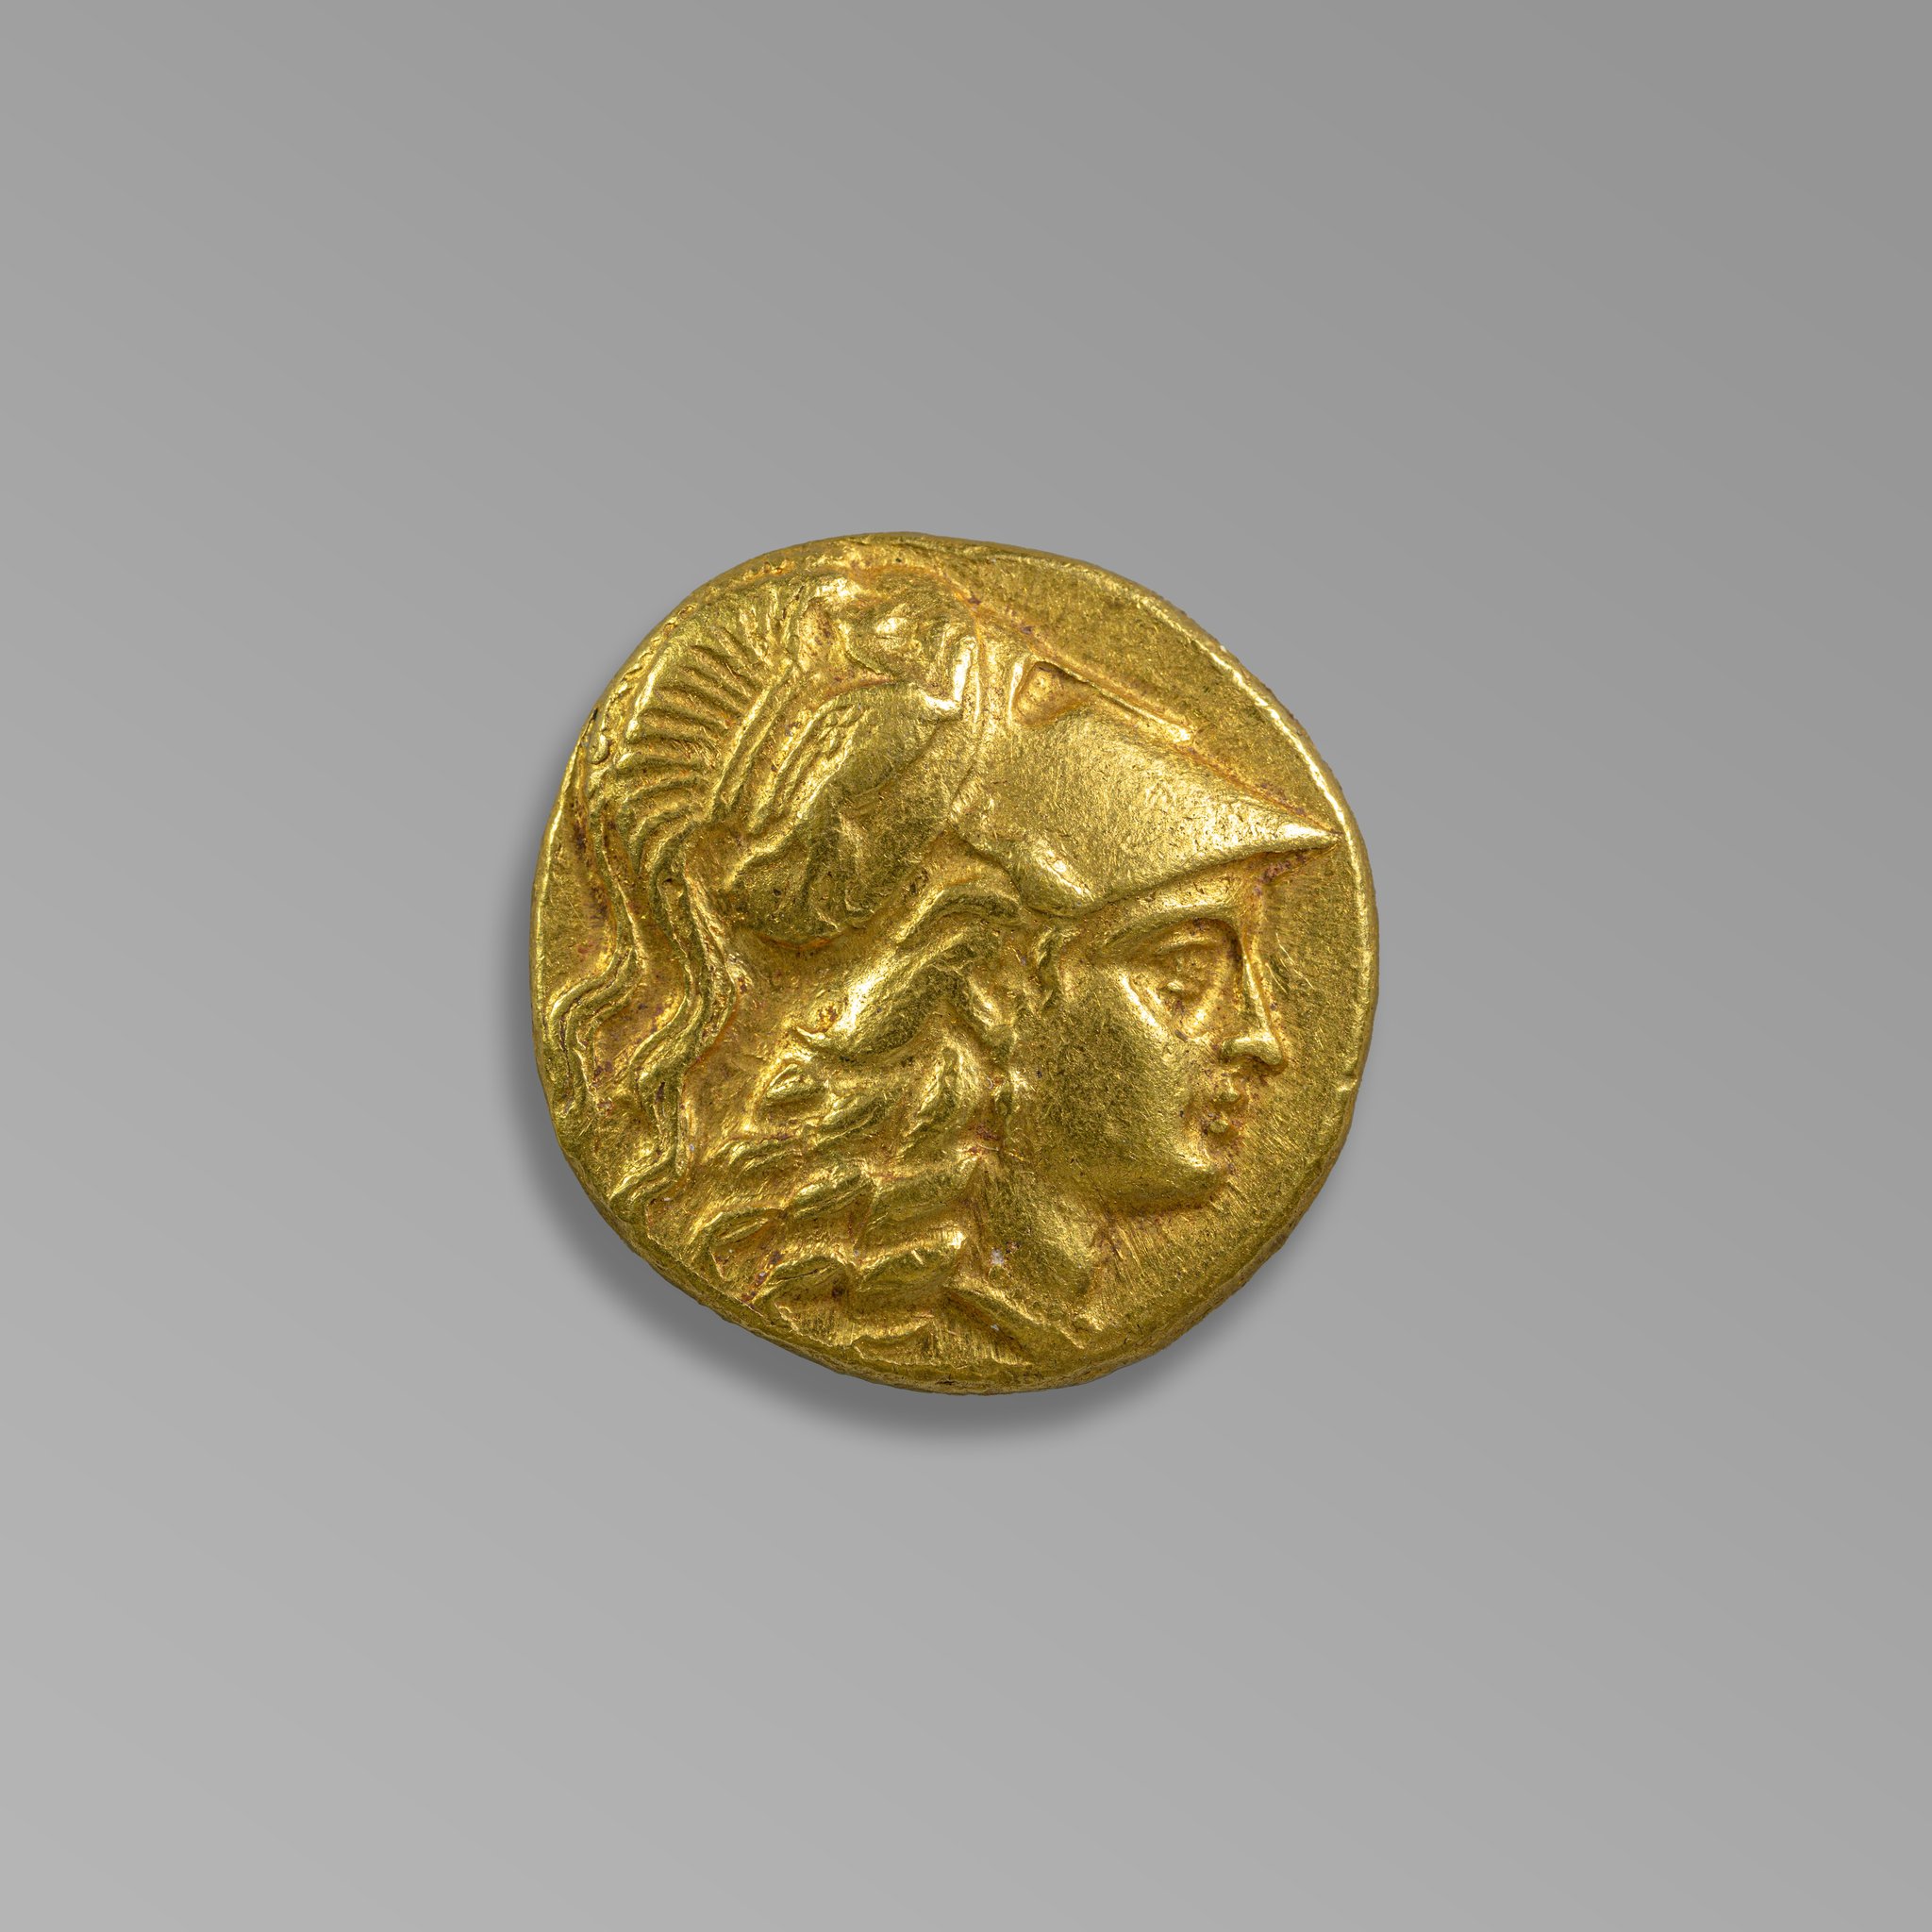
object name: stater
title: Gold stater of Alexander the Great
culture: macedonian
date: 336-323 BCE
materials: gold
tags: alexander the great